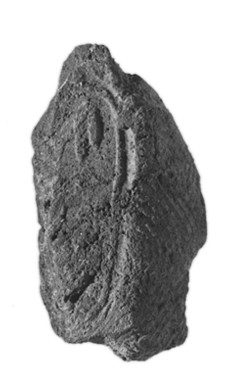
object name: sealing fragment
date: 2030-1640 BCE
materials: clay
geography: egypt